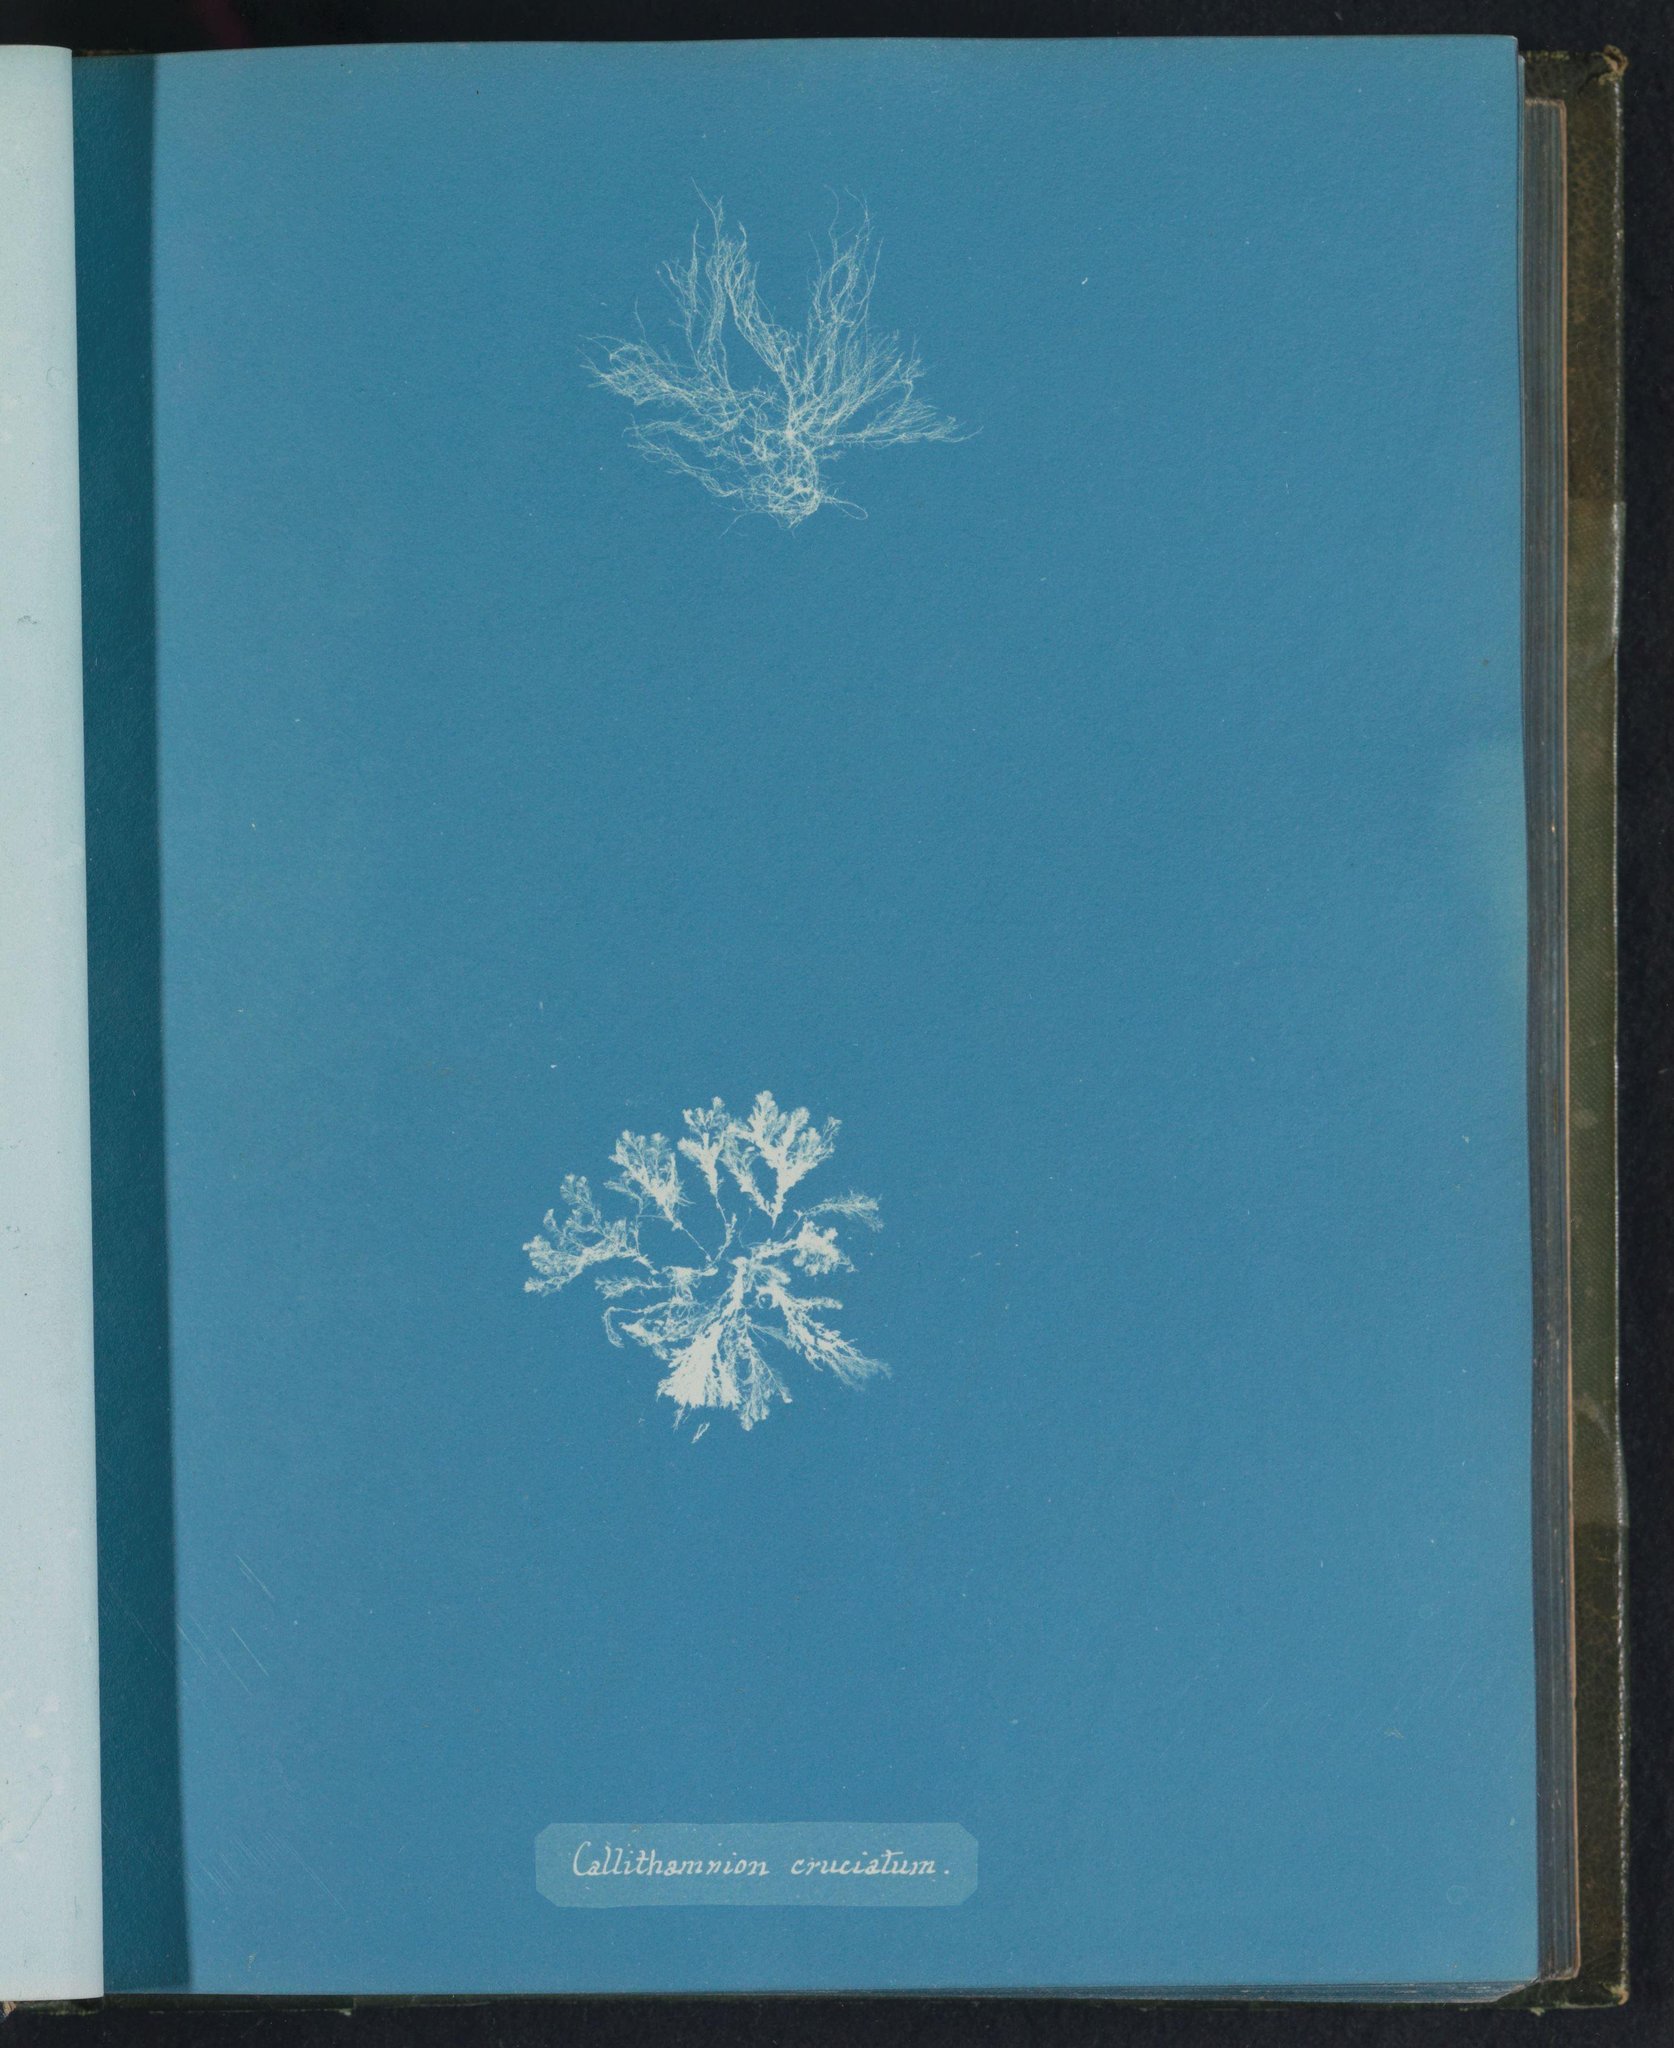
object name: photograph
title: Zeewier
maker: anna atkins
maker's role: fotograaf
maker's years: 1799-1871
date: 1843-1853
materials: photographic support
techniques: cyanotype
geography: united kingdom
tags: algae, seaweed